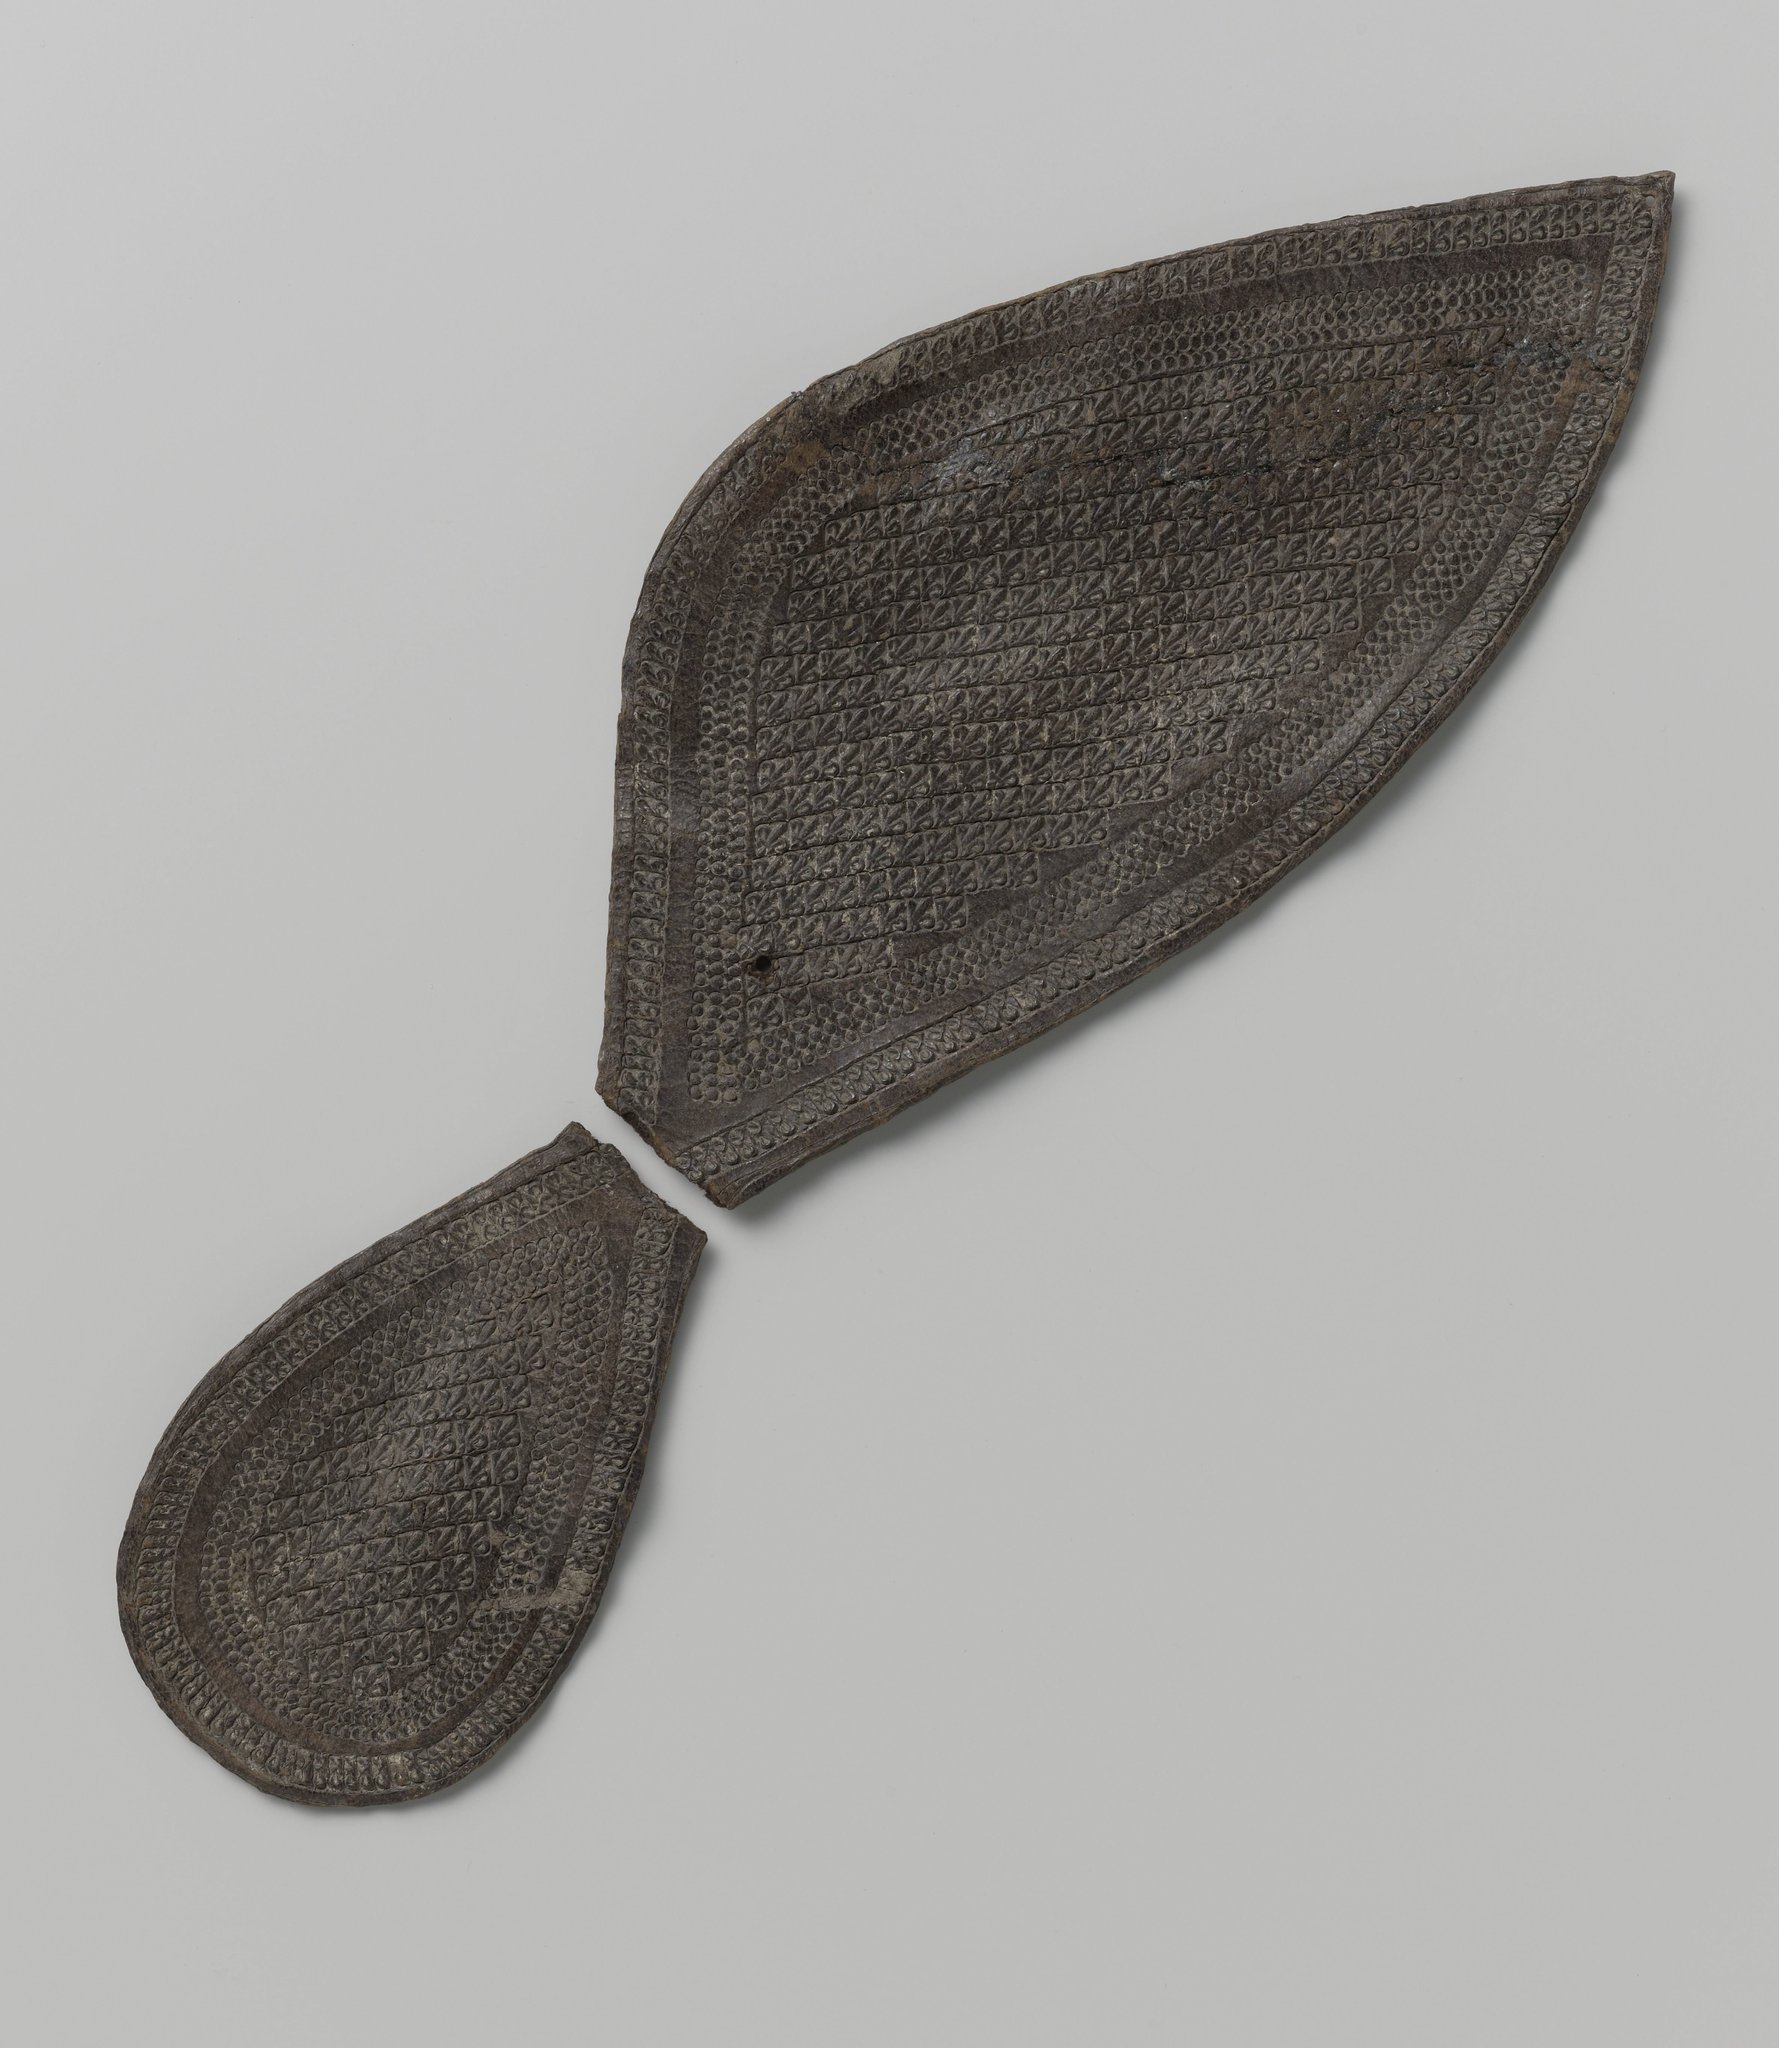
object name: sole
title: Schoenzool van zwart leer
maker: Anonymous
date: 1400-1600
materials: leather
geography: western europe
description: Schoenzool van zwart leer. Ingeperste versiering van onder andere leliën. Spitse neus, ronde hiel, sterk ingesnoerde middenvoet. Opschrift: een schoenzool gevonden 10 voet onder den grond te schoonhoven 1876.